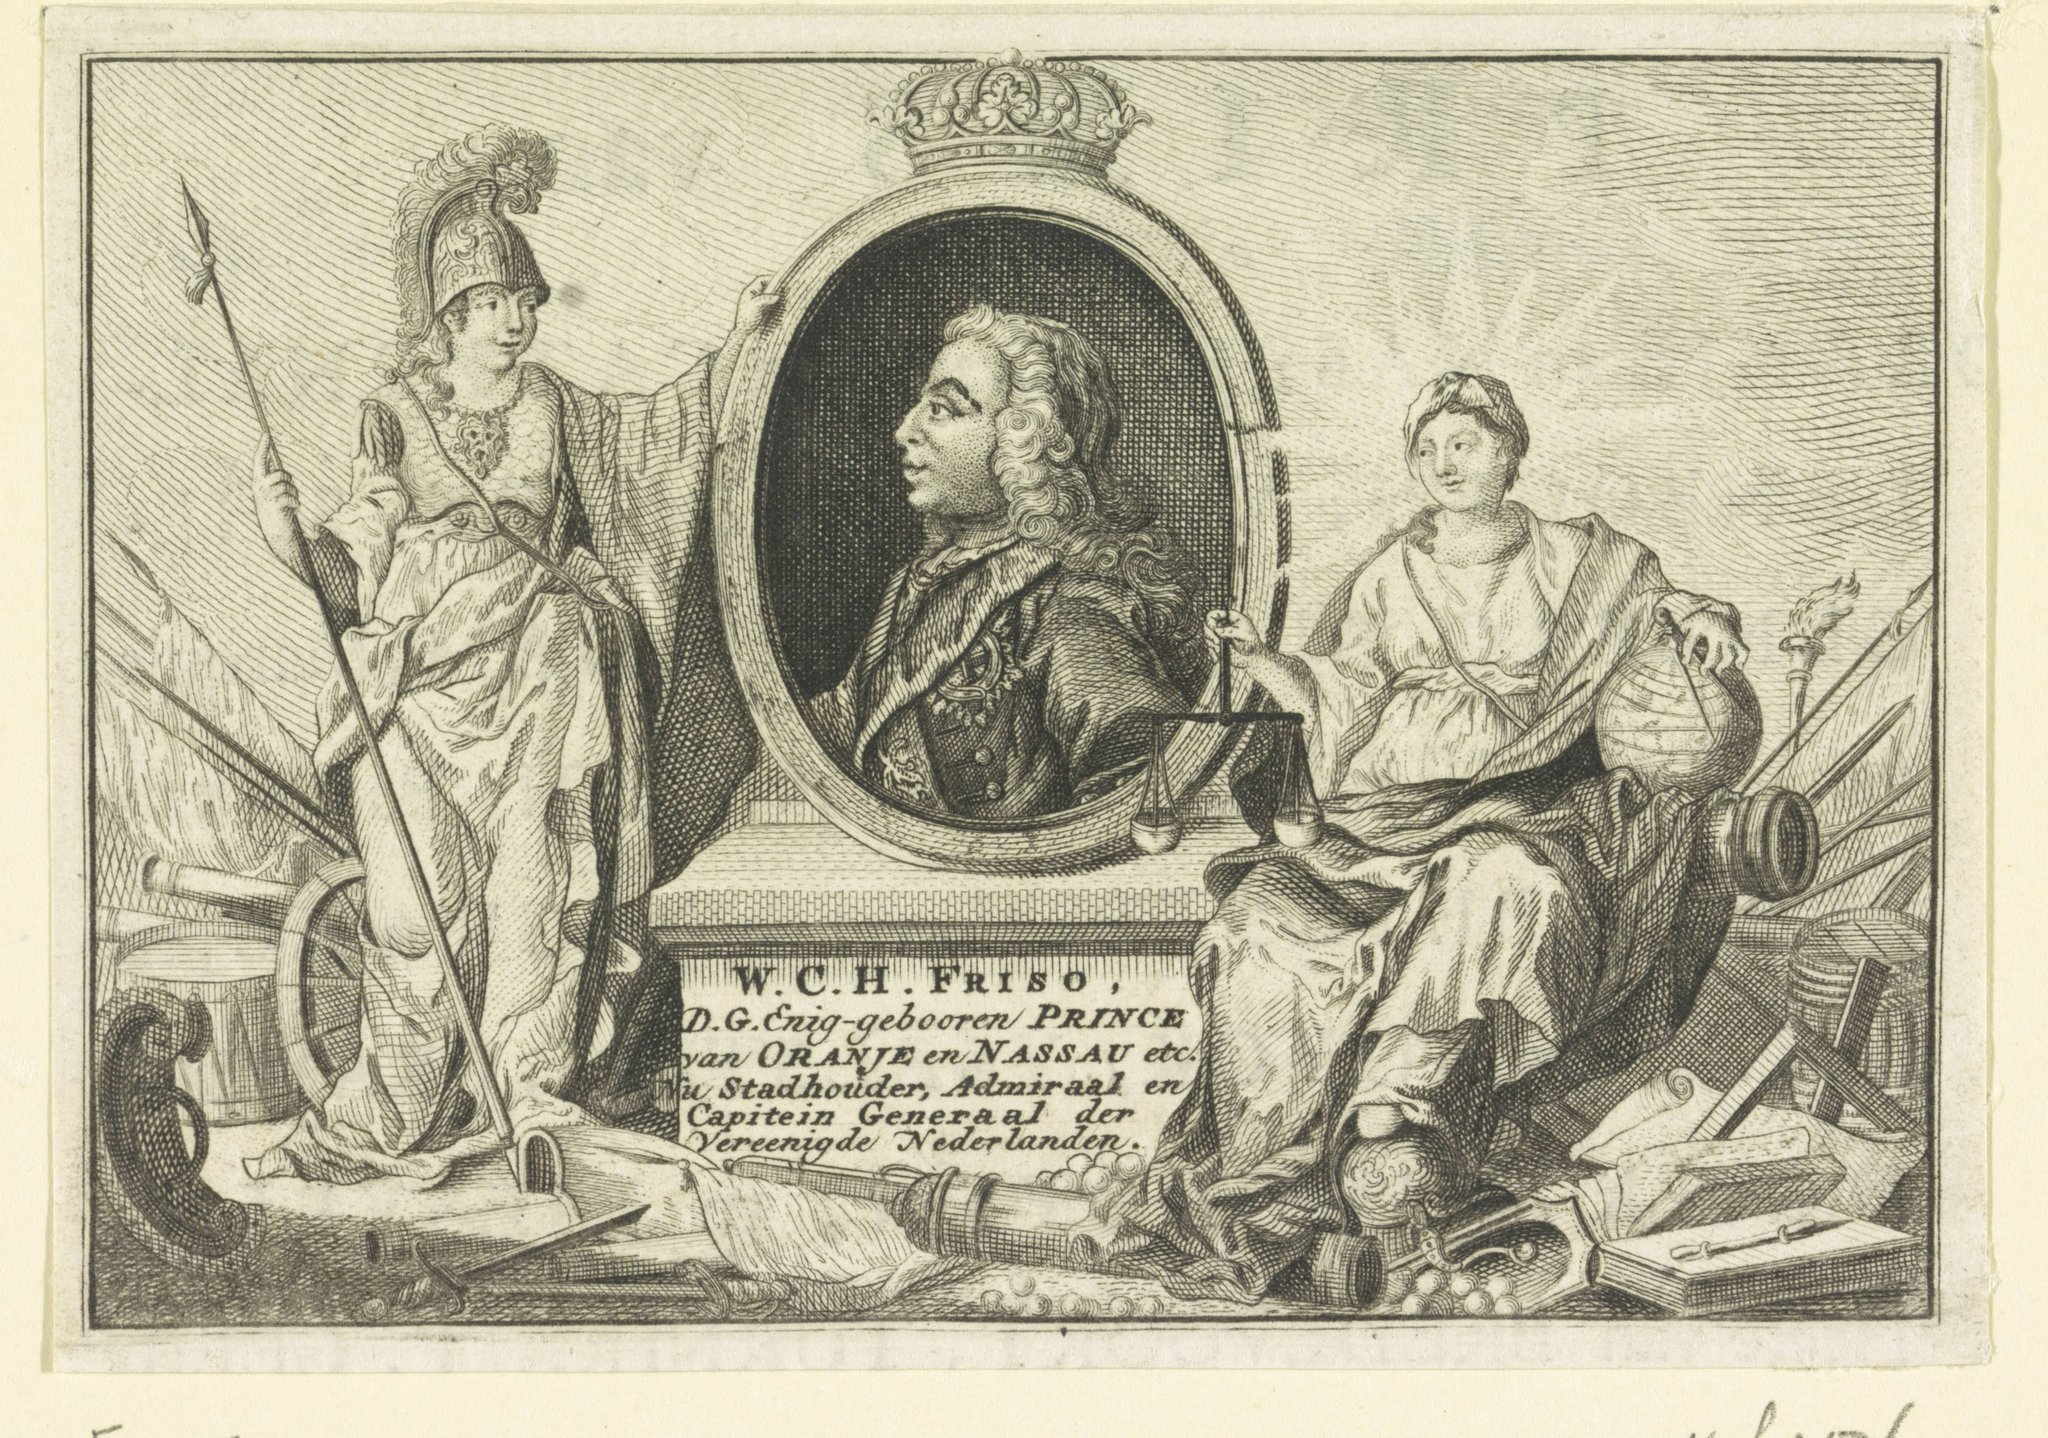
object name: book illustration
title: Portret van Willem IV, prins van Oranje-Nassau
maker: Anonymous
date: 1747-1799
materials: paper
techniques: engraving, etching, letterpress printing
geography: low countries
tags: willem iv (prins van oranje-nassau), (story of) minerva (pallas, athena)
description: De hier vermelde titel verwijst naar de hoogst verkregen titel van de geportretteerde, niet per se naar de titel die de geportretteerde op deze voorstelling draagt.